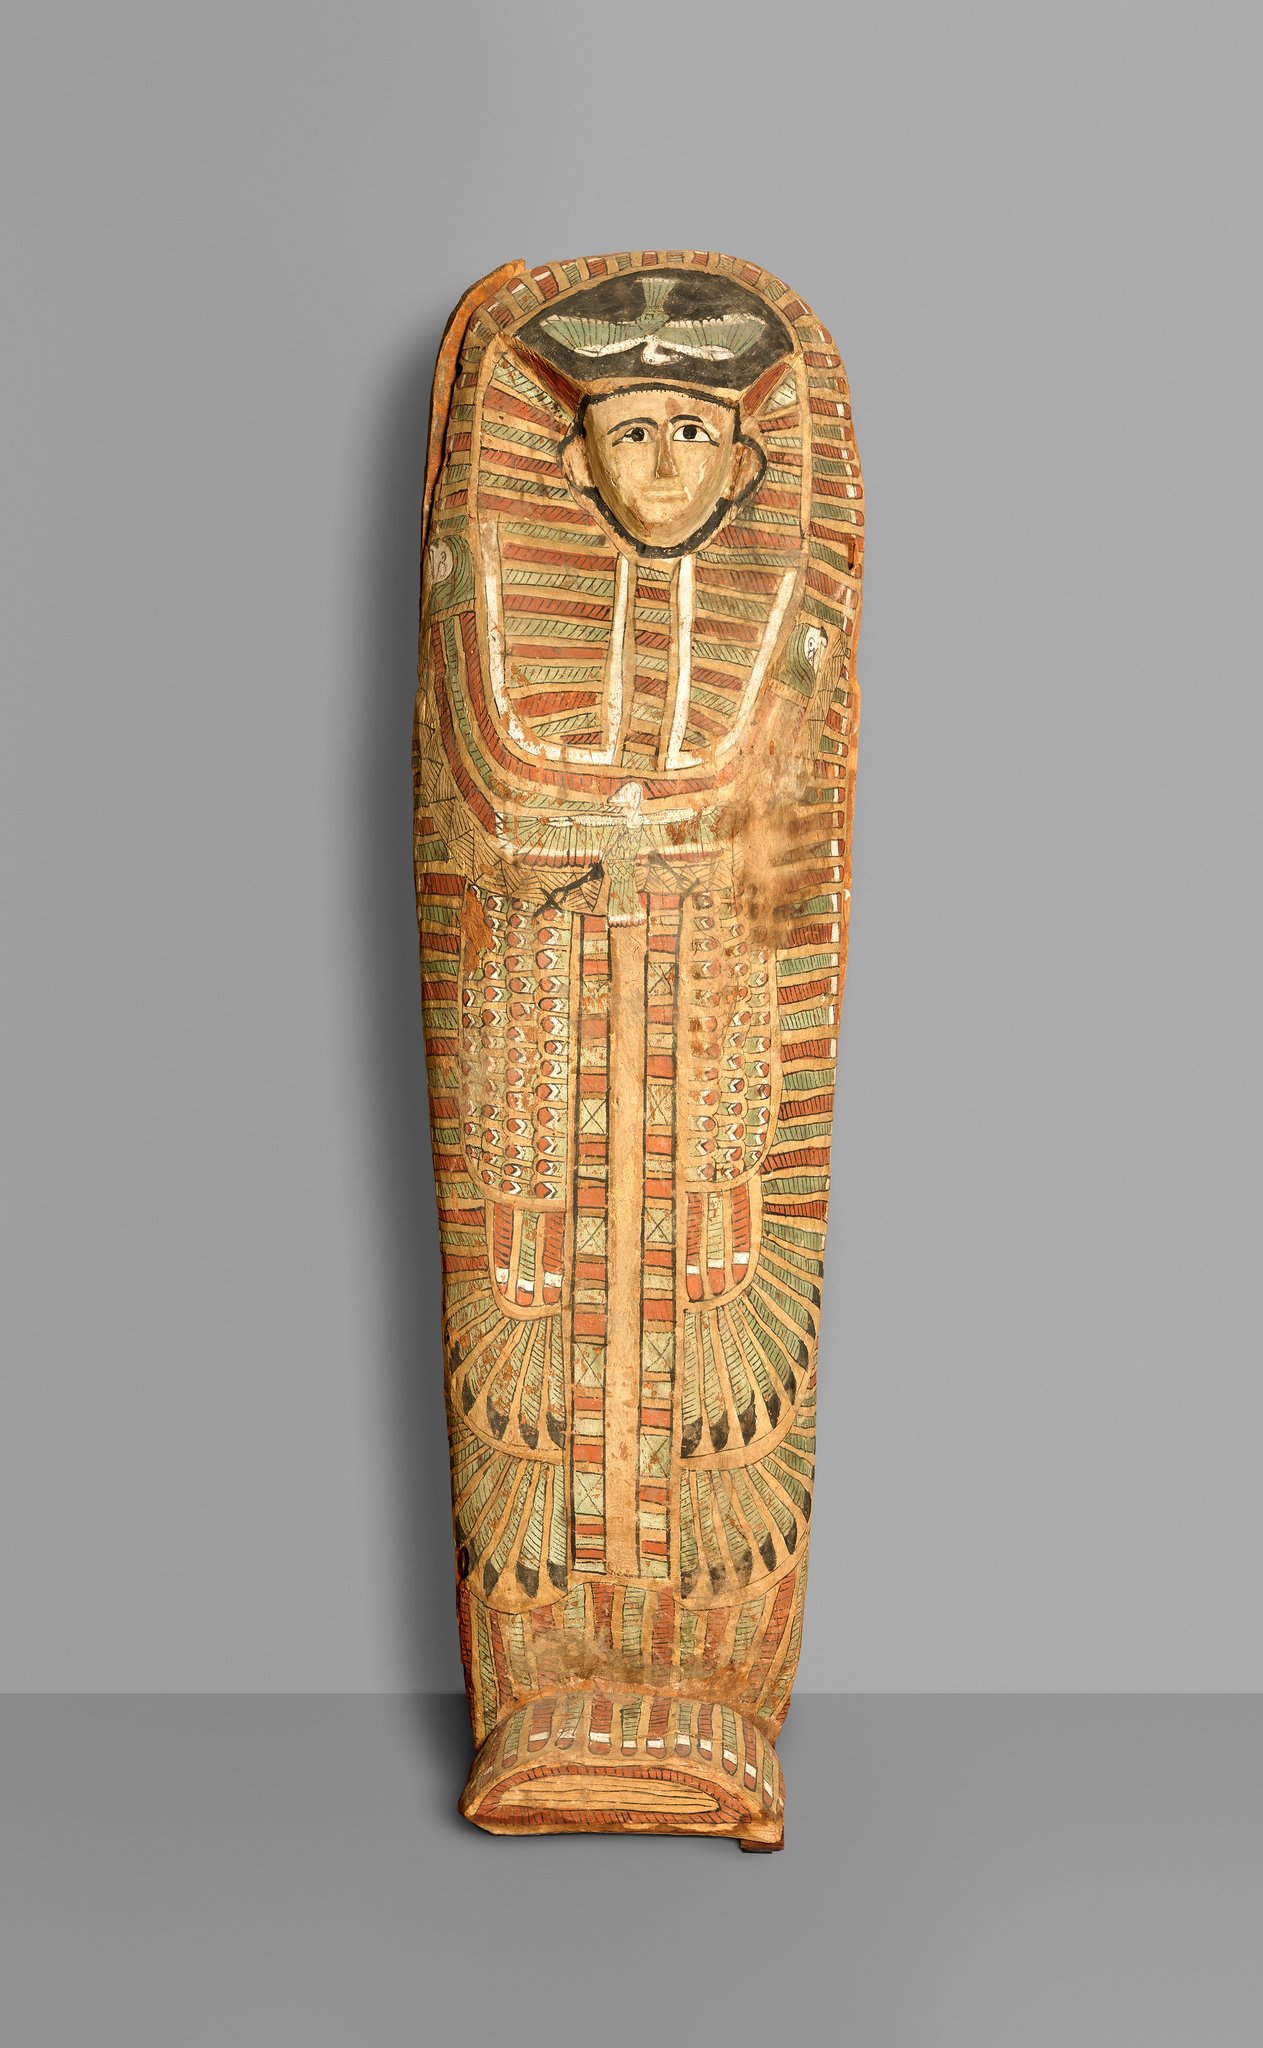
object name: coffin, rishi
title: Rishi coffin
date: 1580-1479 BCE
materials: paint, plaster, wood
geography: egypt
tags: coffins